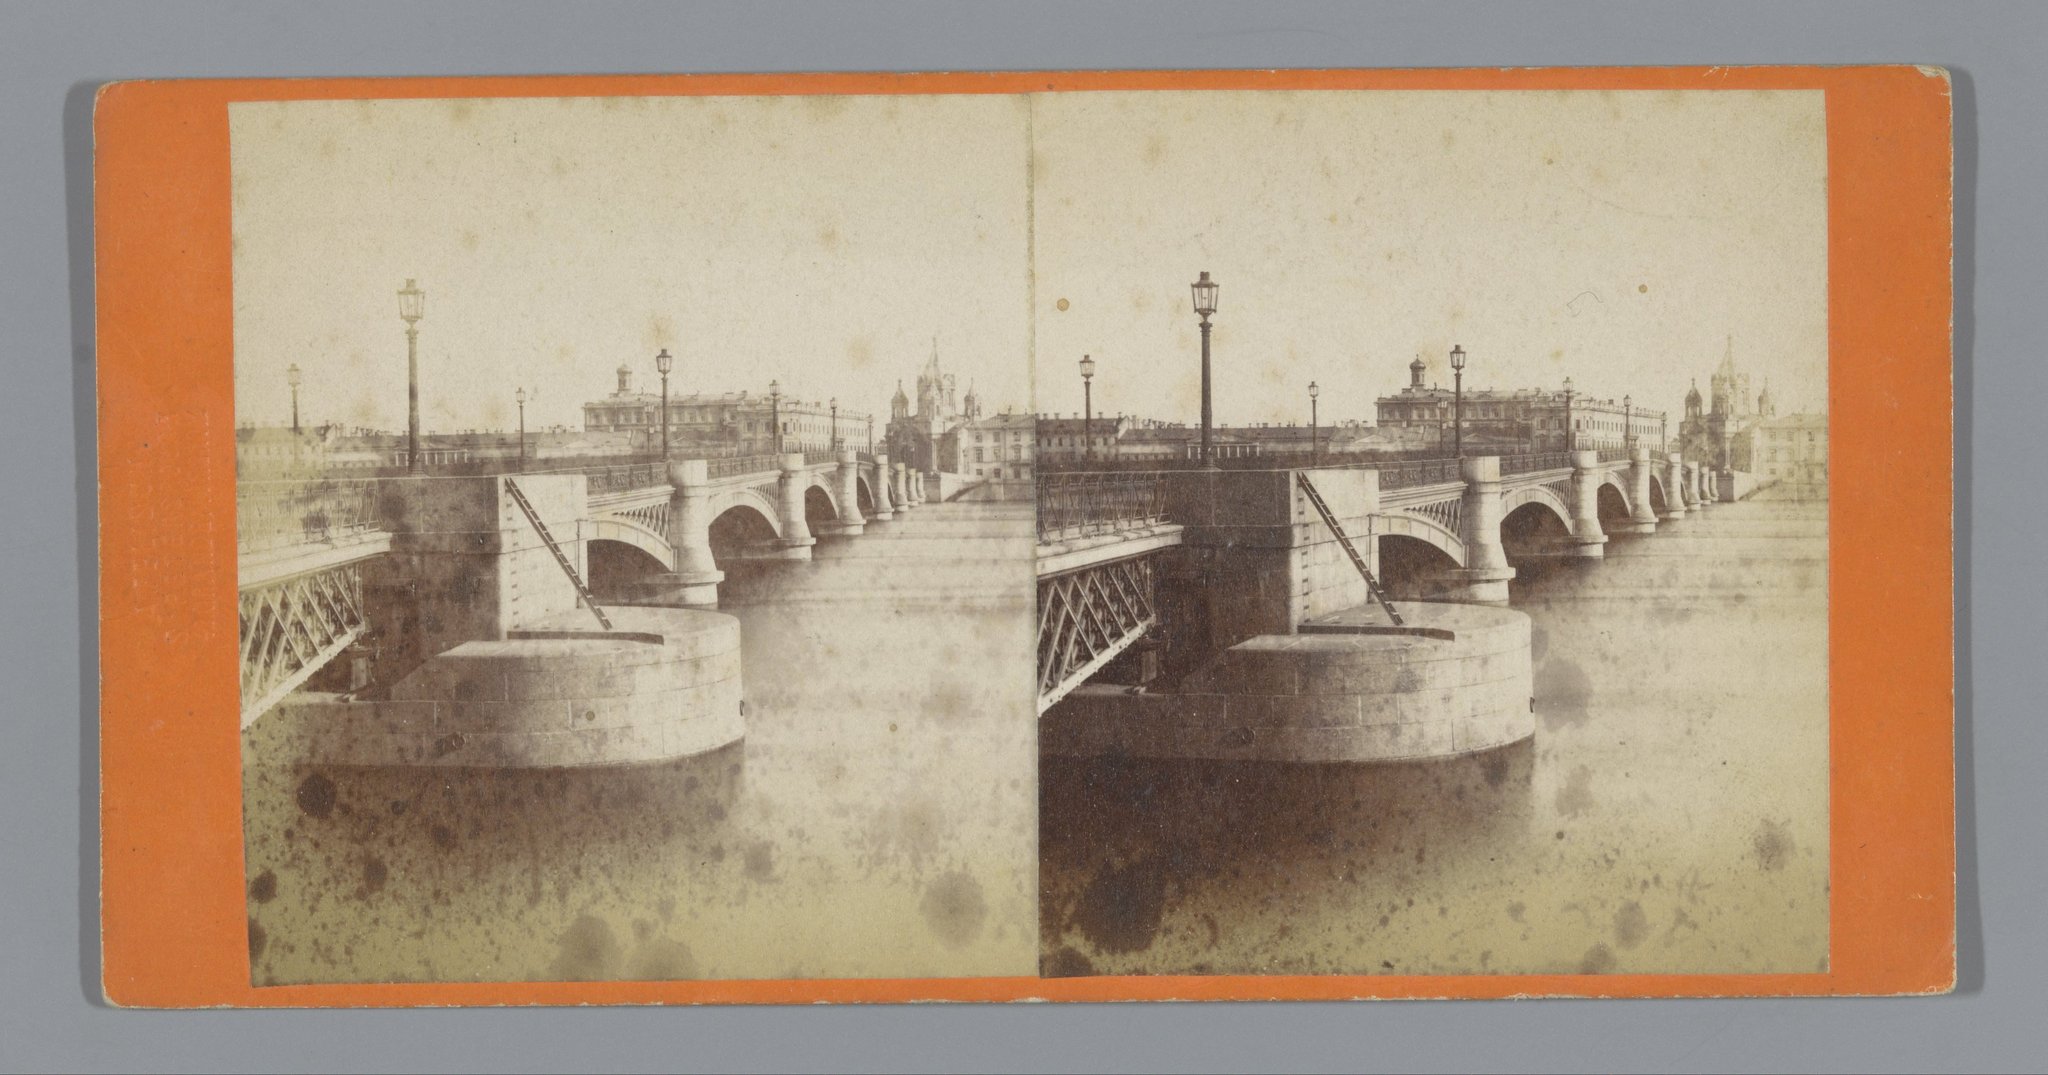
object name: stereograph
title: Gezicht op een brug in Sint-Petersburg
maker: albert felisch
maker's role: fotograaf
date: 1850-1880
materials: cardboard, photographic support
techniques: albumen print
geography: sint-petersburg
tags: bridge in city across river, canal, etc.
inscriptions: inscription: ‘St Petersburg [...]’, name: ‘A. FELISCH. S. PETERSBOURG 42. GRANDEMORSKOY.’